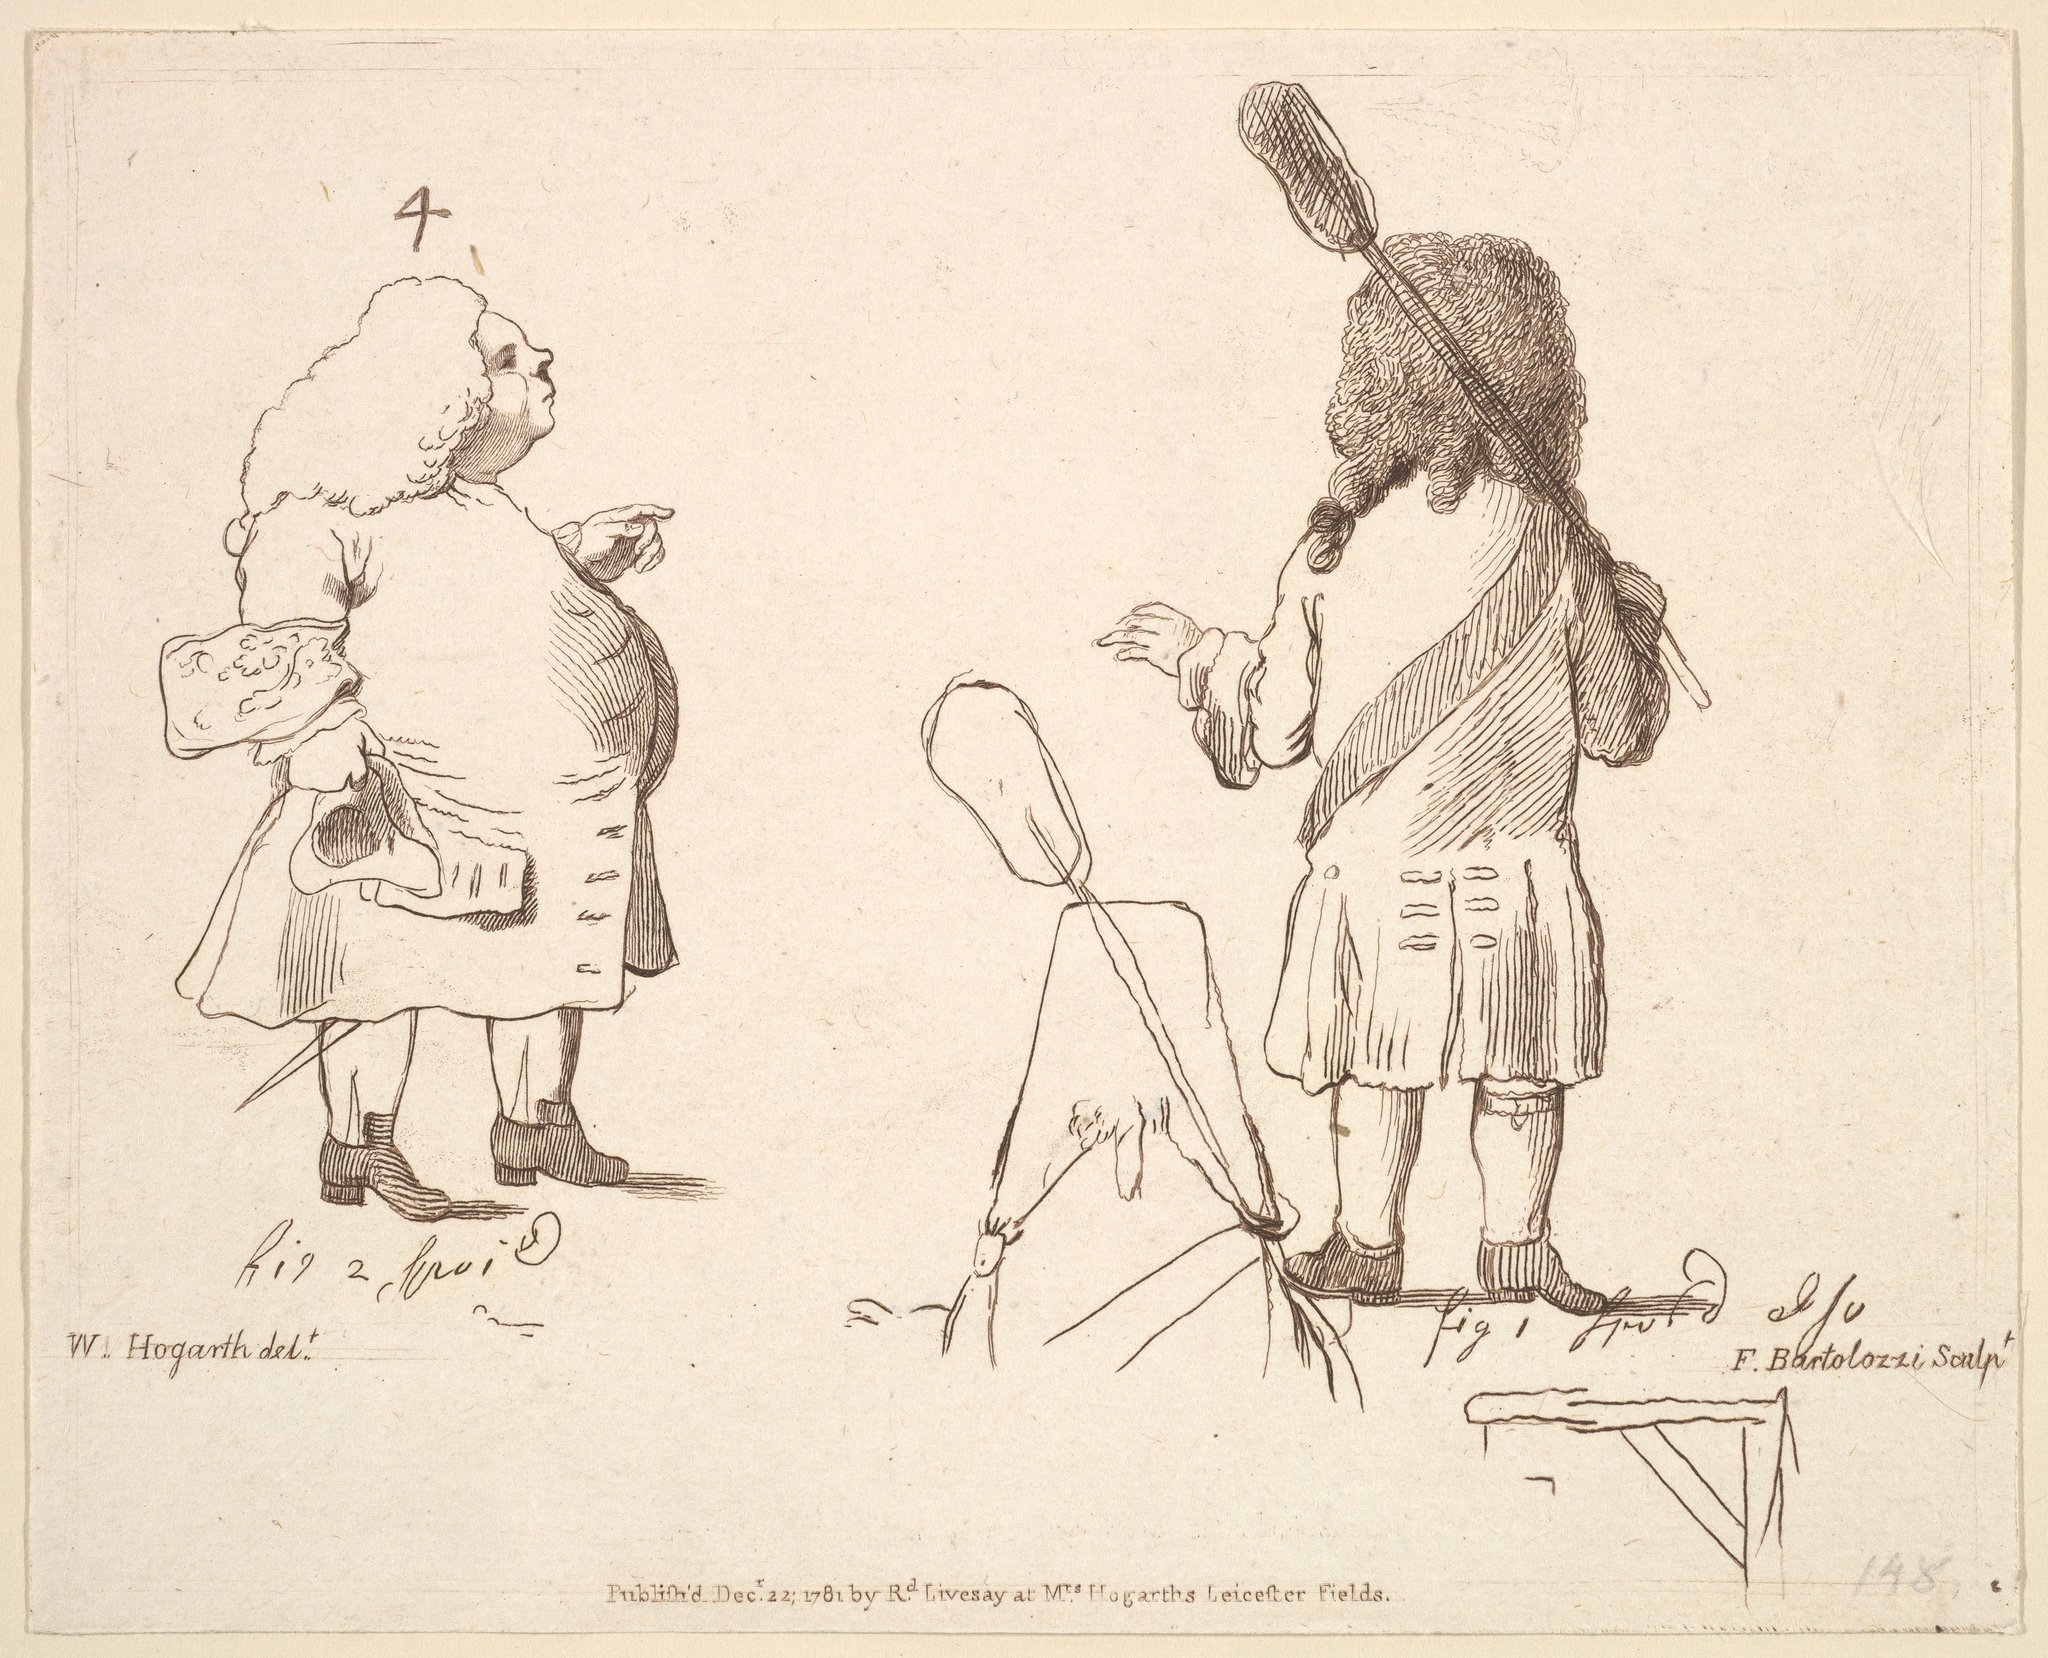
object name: print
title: Caricatures of Lord Melcombe and Lord Winchelsea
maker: francesco bartolozzi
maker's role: etcher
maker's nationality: italian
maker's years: 1728-1815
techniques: etching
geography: london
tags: men